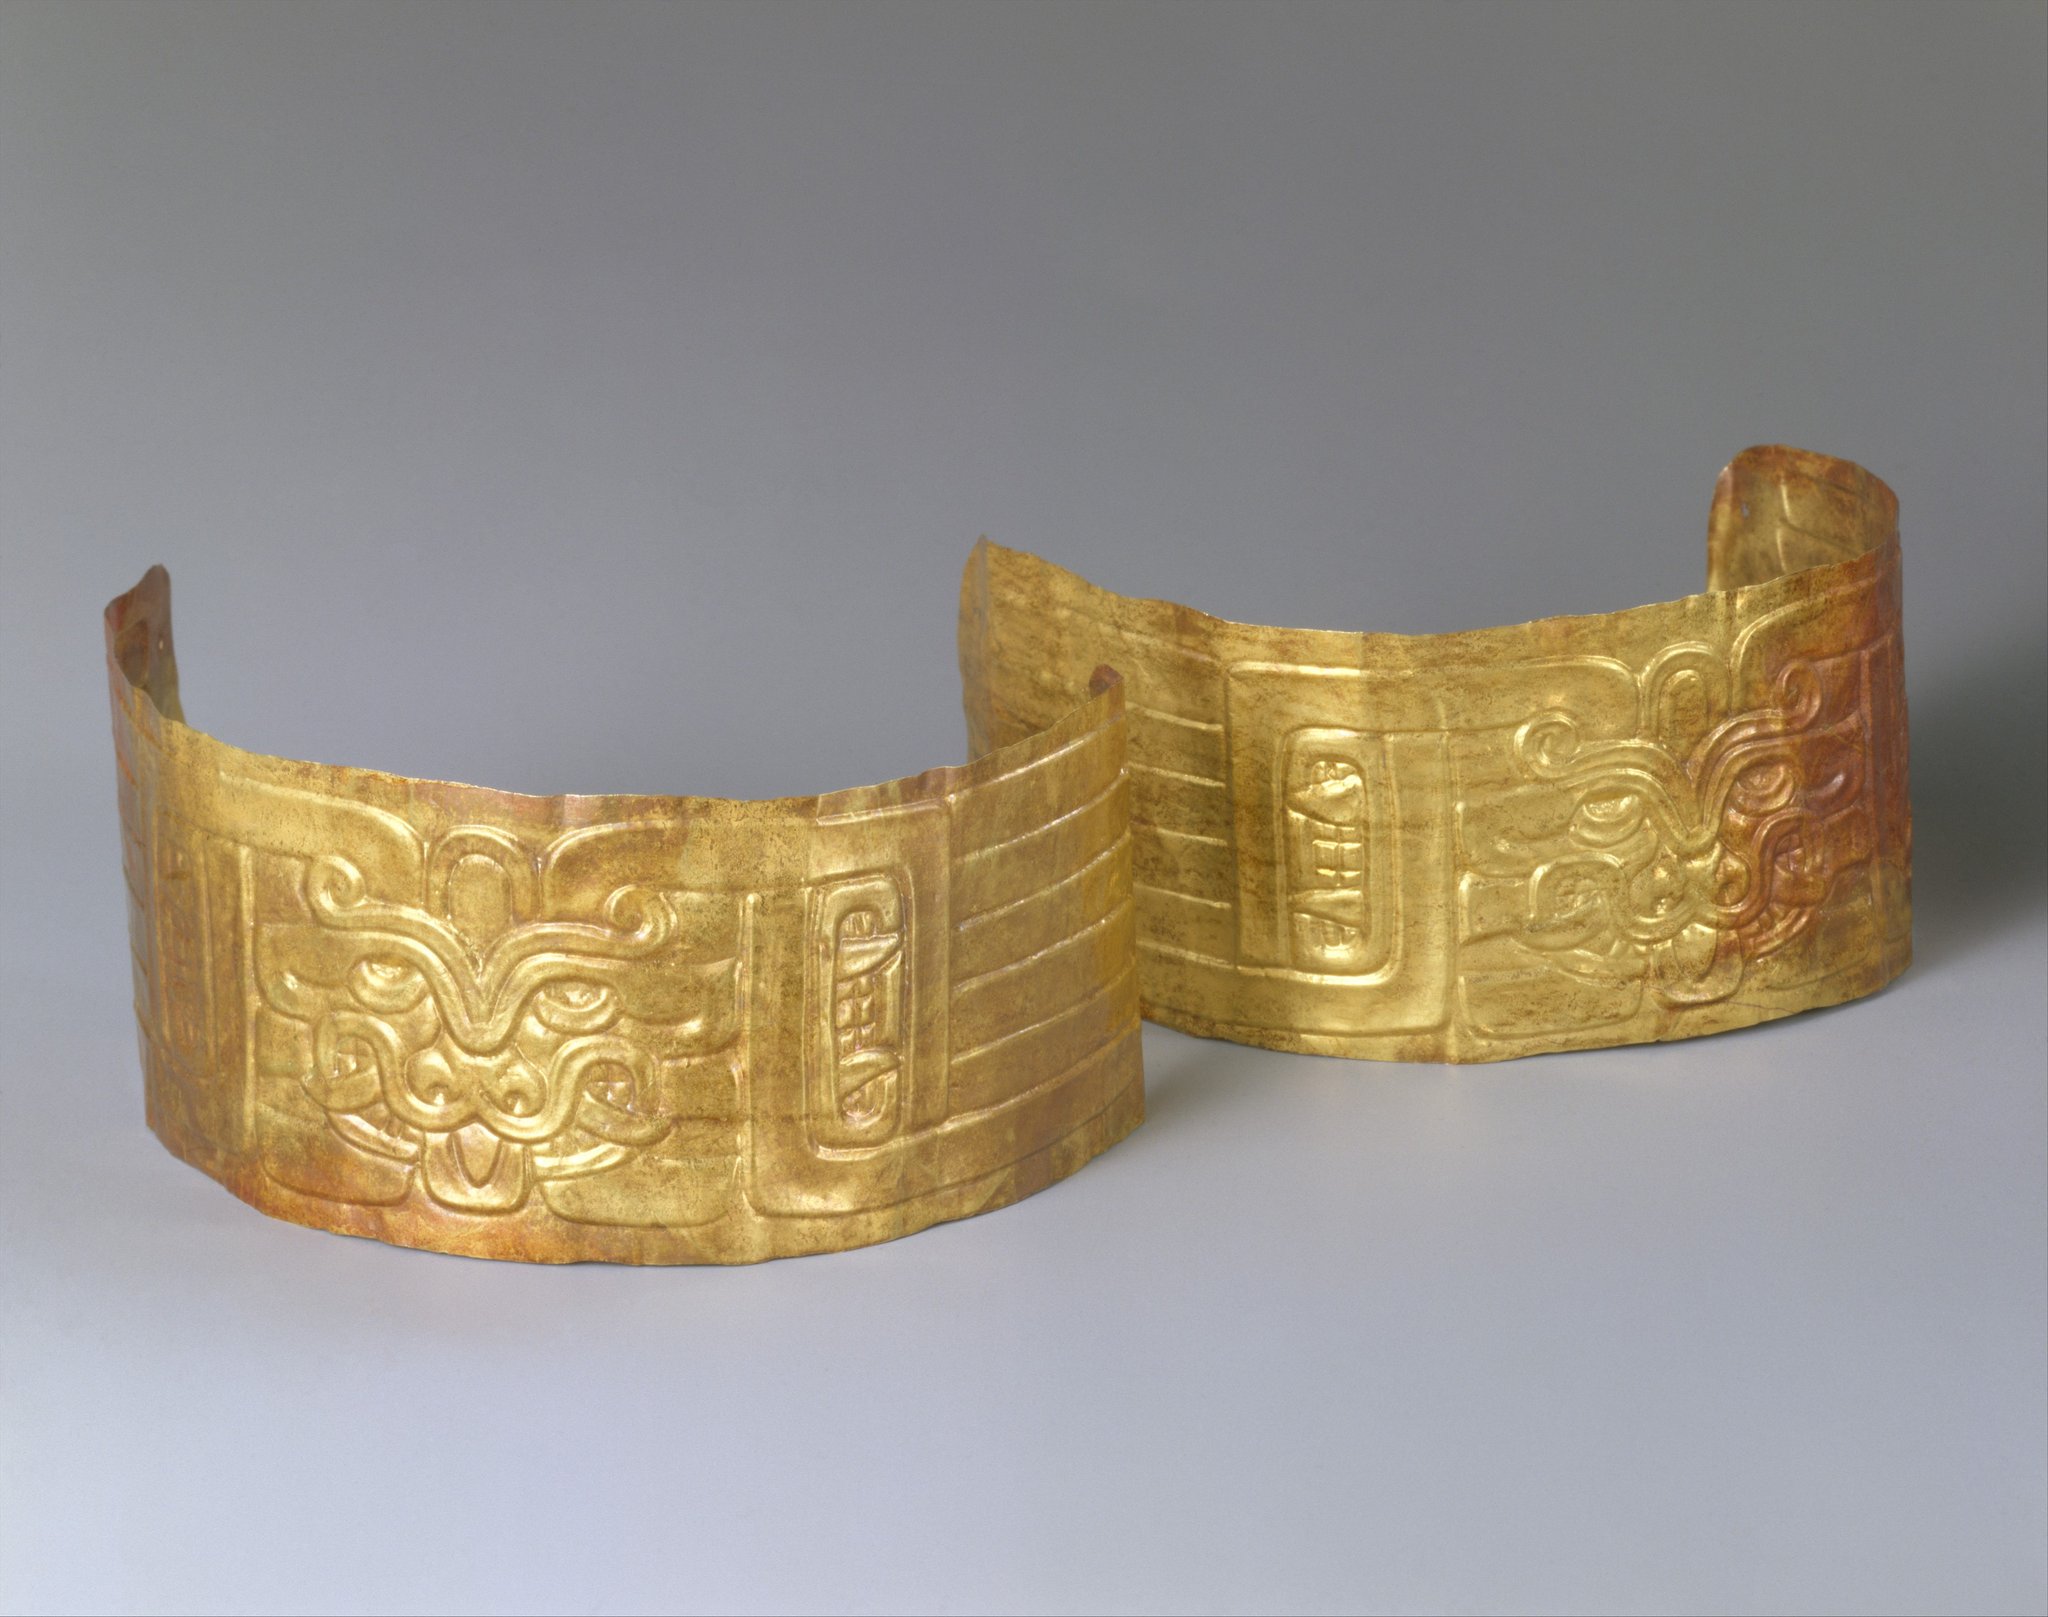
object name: armband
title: Arm bands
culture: chavín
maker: chavín artist(s)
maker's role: artist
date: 800-500 BCE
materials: gold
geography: peru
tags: animals